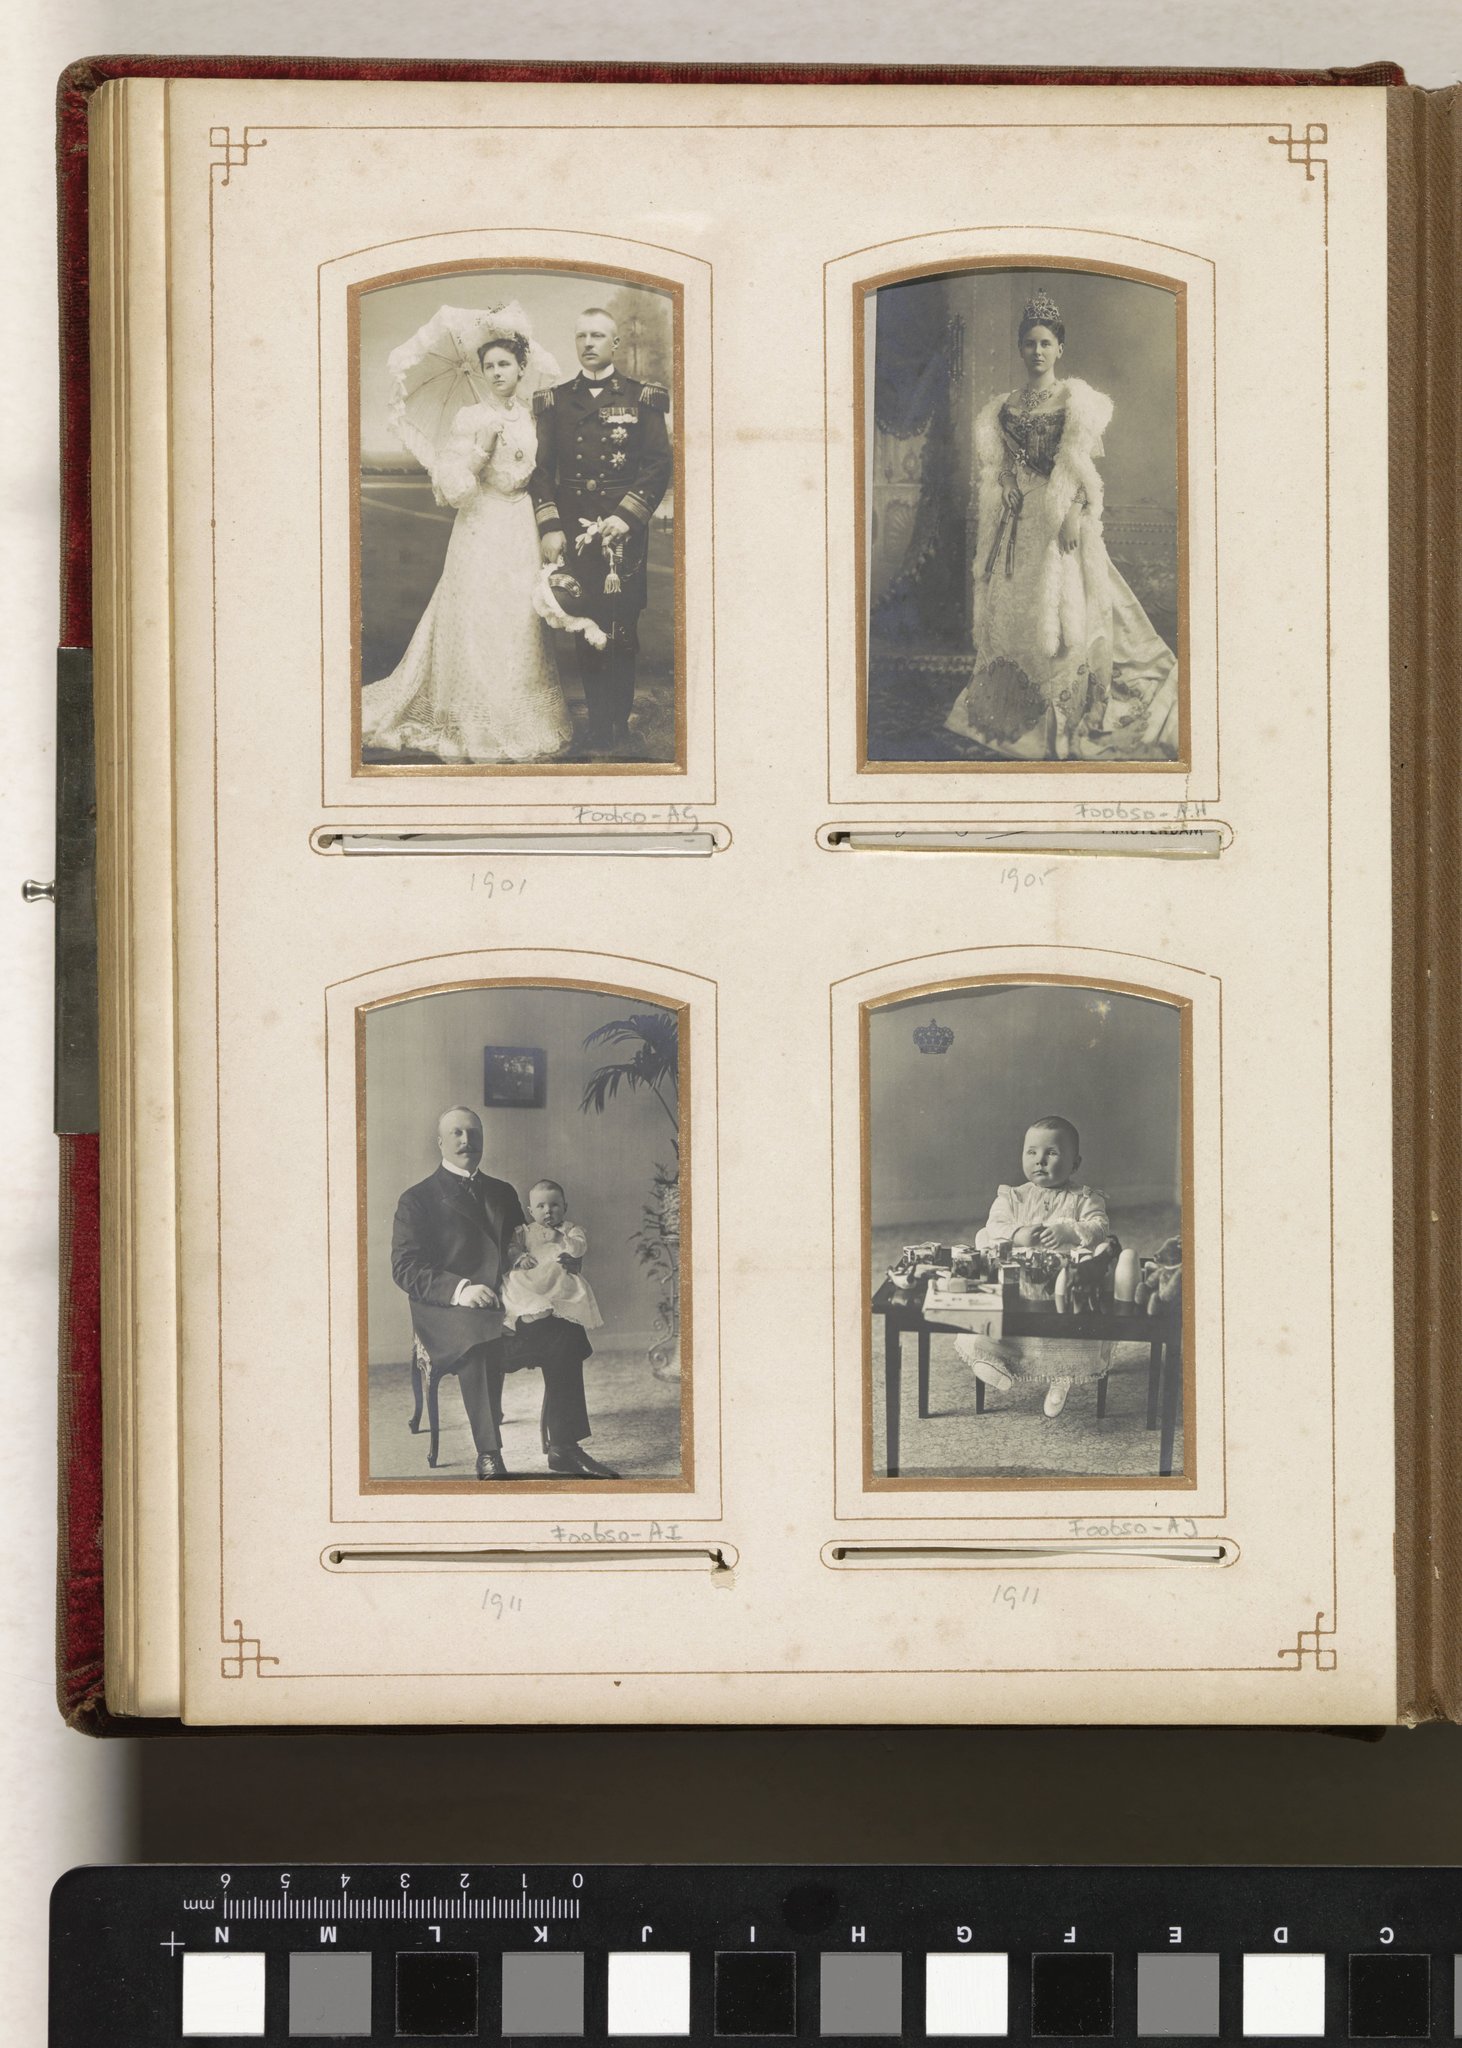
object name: album leaf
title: Portret van prinses Juliana met speelgoed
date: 1911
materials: paper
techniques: gelatin silver print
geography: netherlands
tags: the hague, juliana of the netherlands, historical persons - bb - woman, crown princess - bb - female ruler